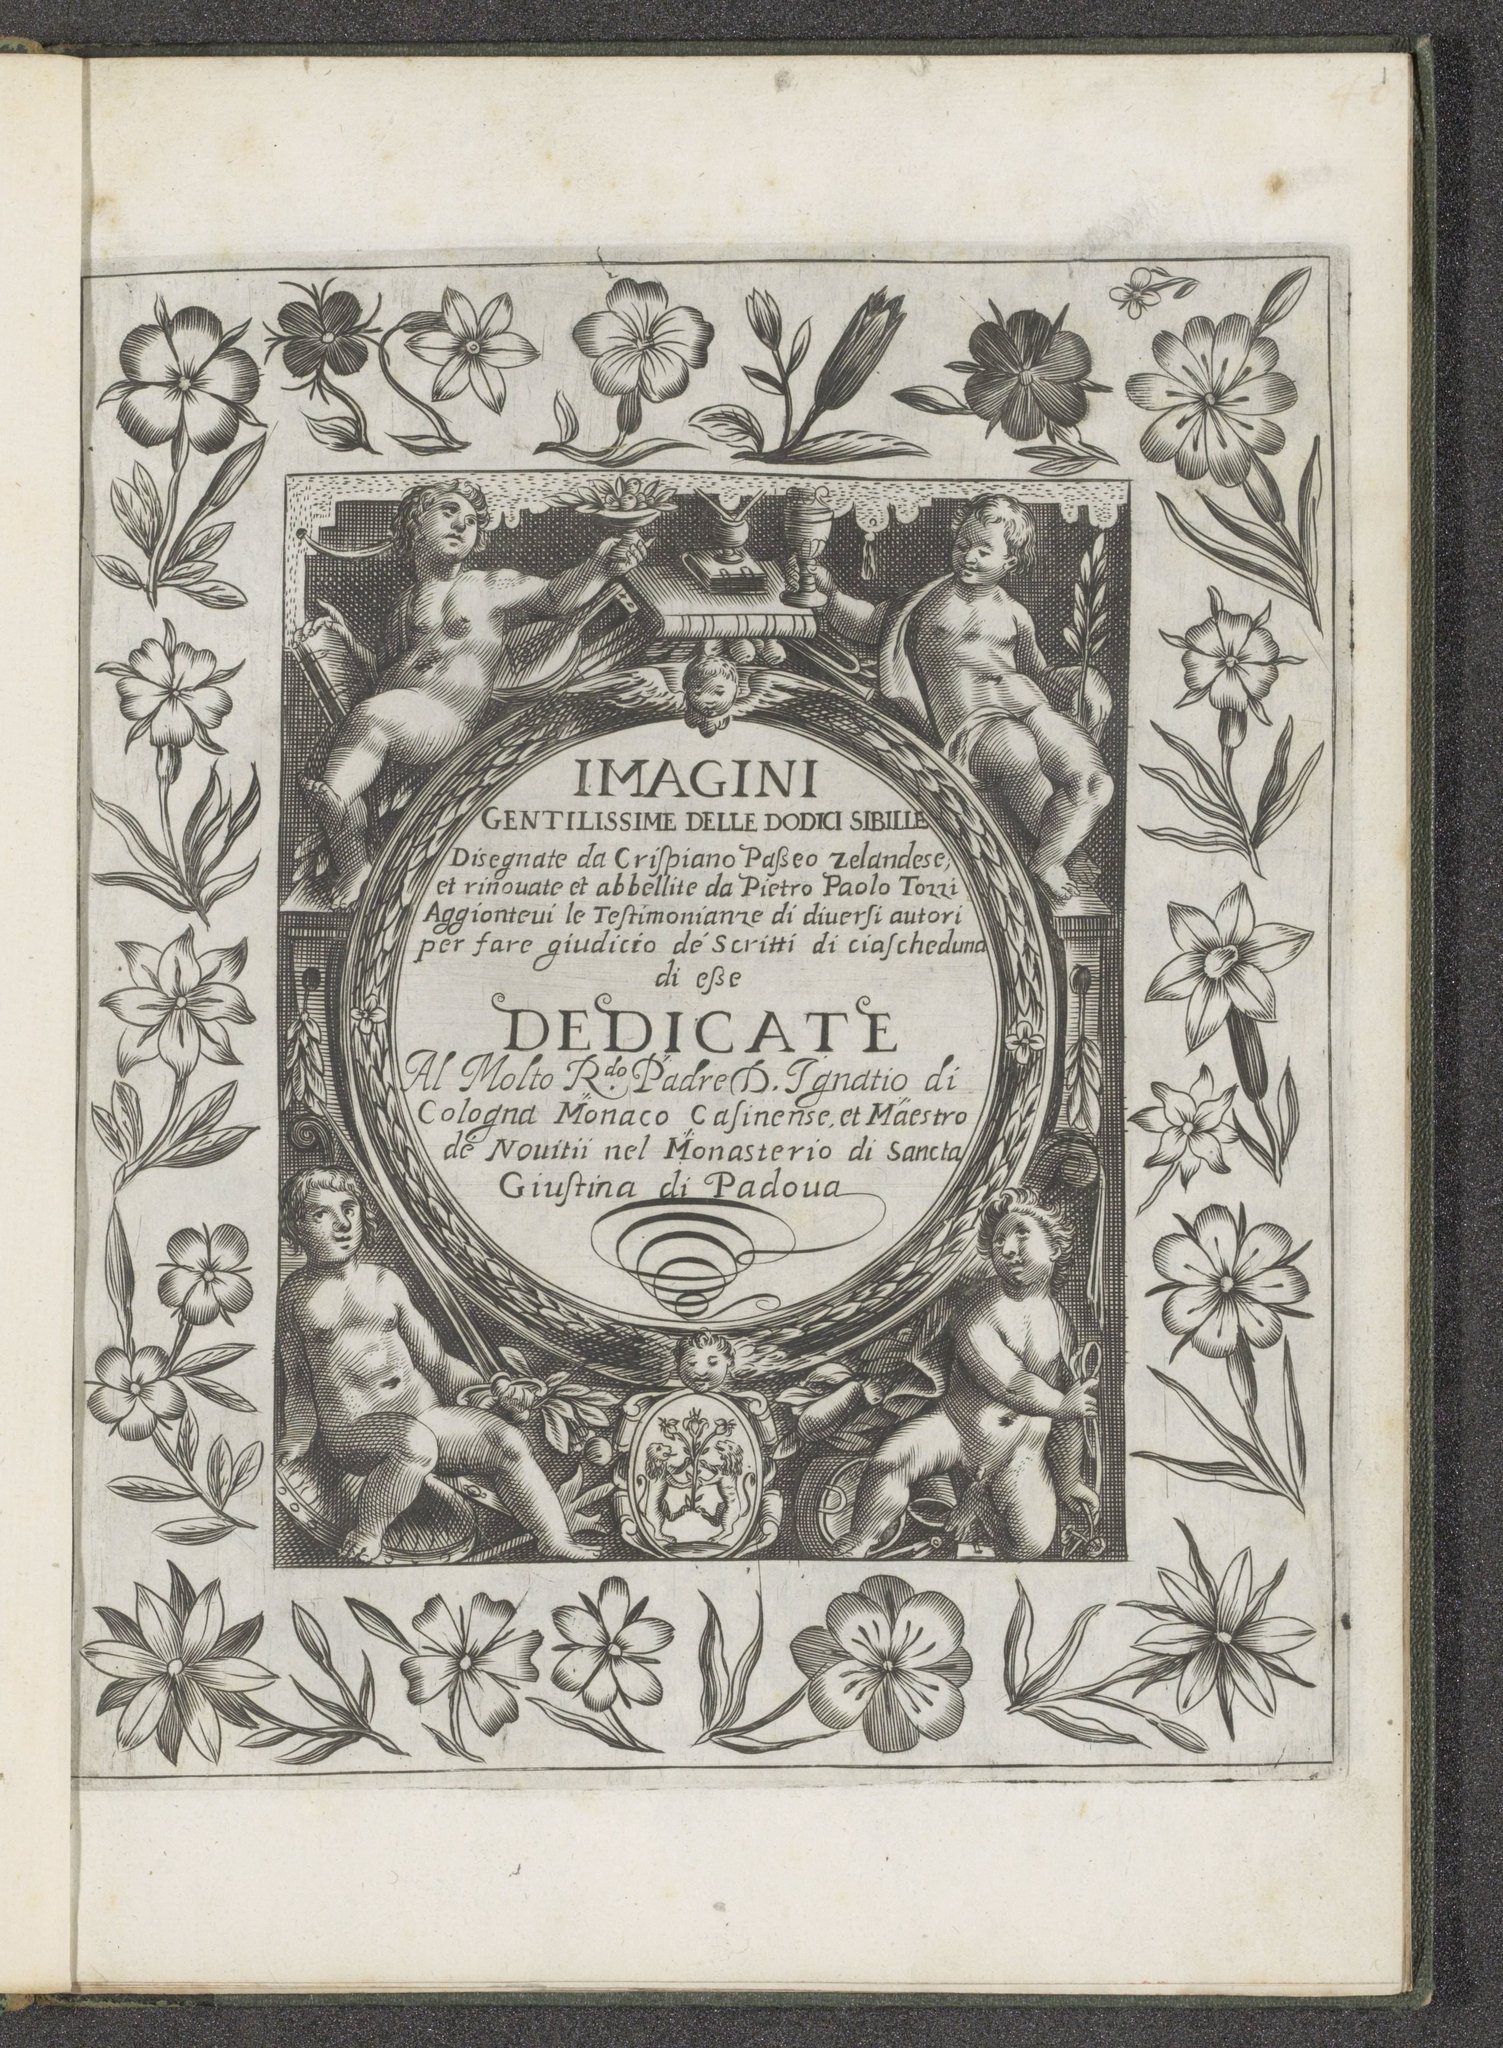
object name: print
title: Titelprent voor een serie met de twaalf sibillen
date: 1601-1627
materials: paper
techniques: engraving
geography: padua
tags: flowers, cupids: 'amores', 'amoretti', 'putti'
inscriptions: number: ‘46’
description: Medaillon met de titel en een opdracht in het Italiaans. In de vier hoeken putti met attribuut en diverse decoraties. Rondom een kader met bloemen. Titelprent voor een serie met de twaalf sibillen. Prent maakt deel uit van een album.